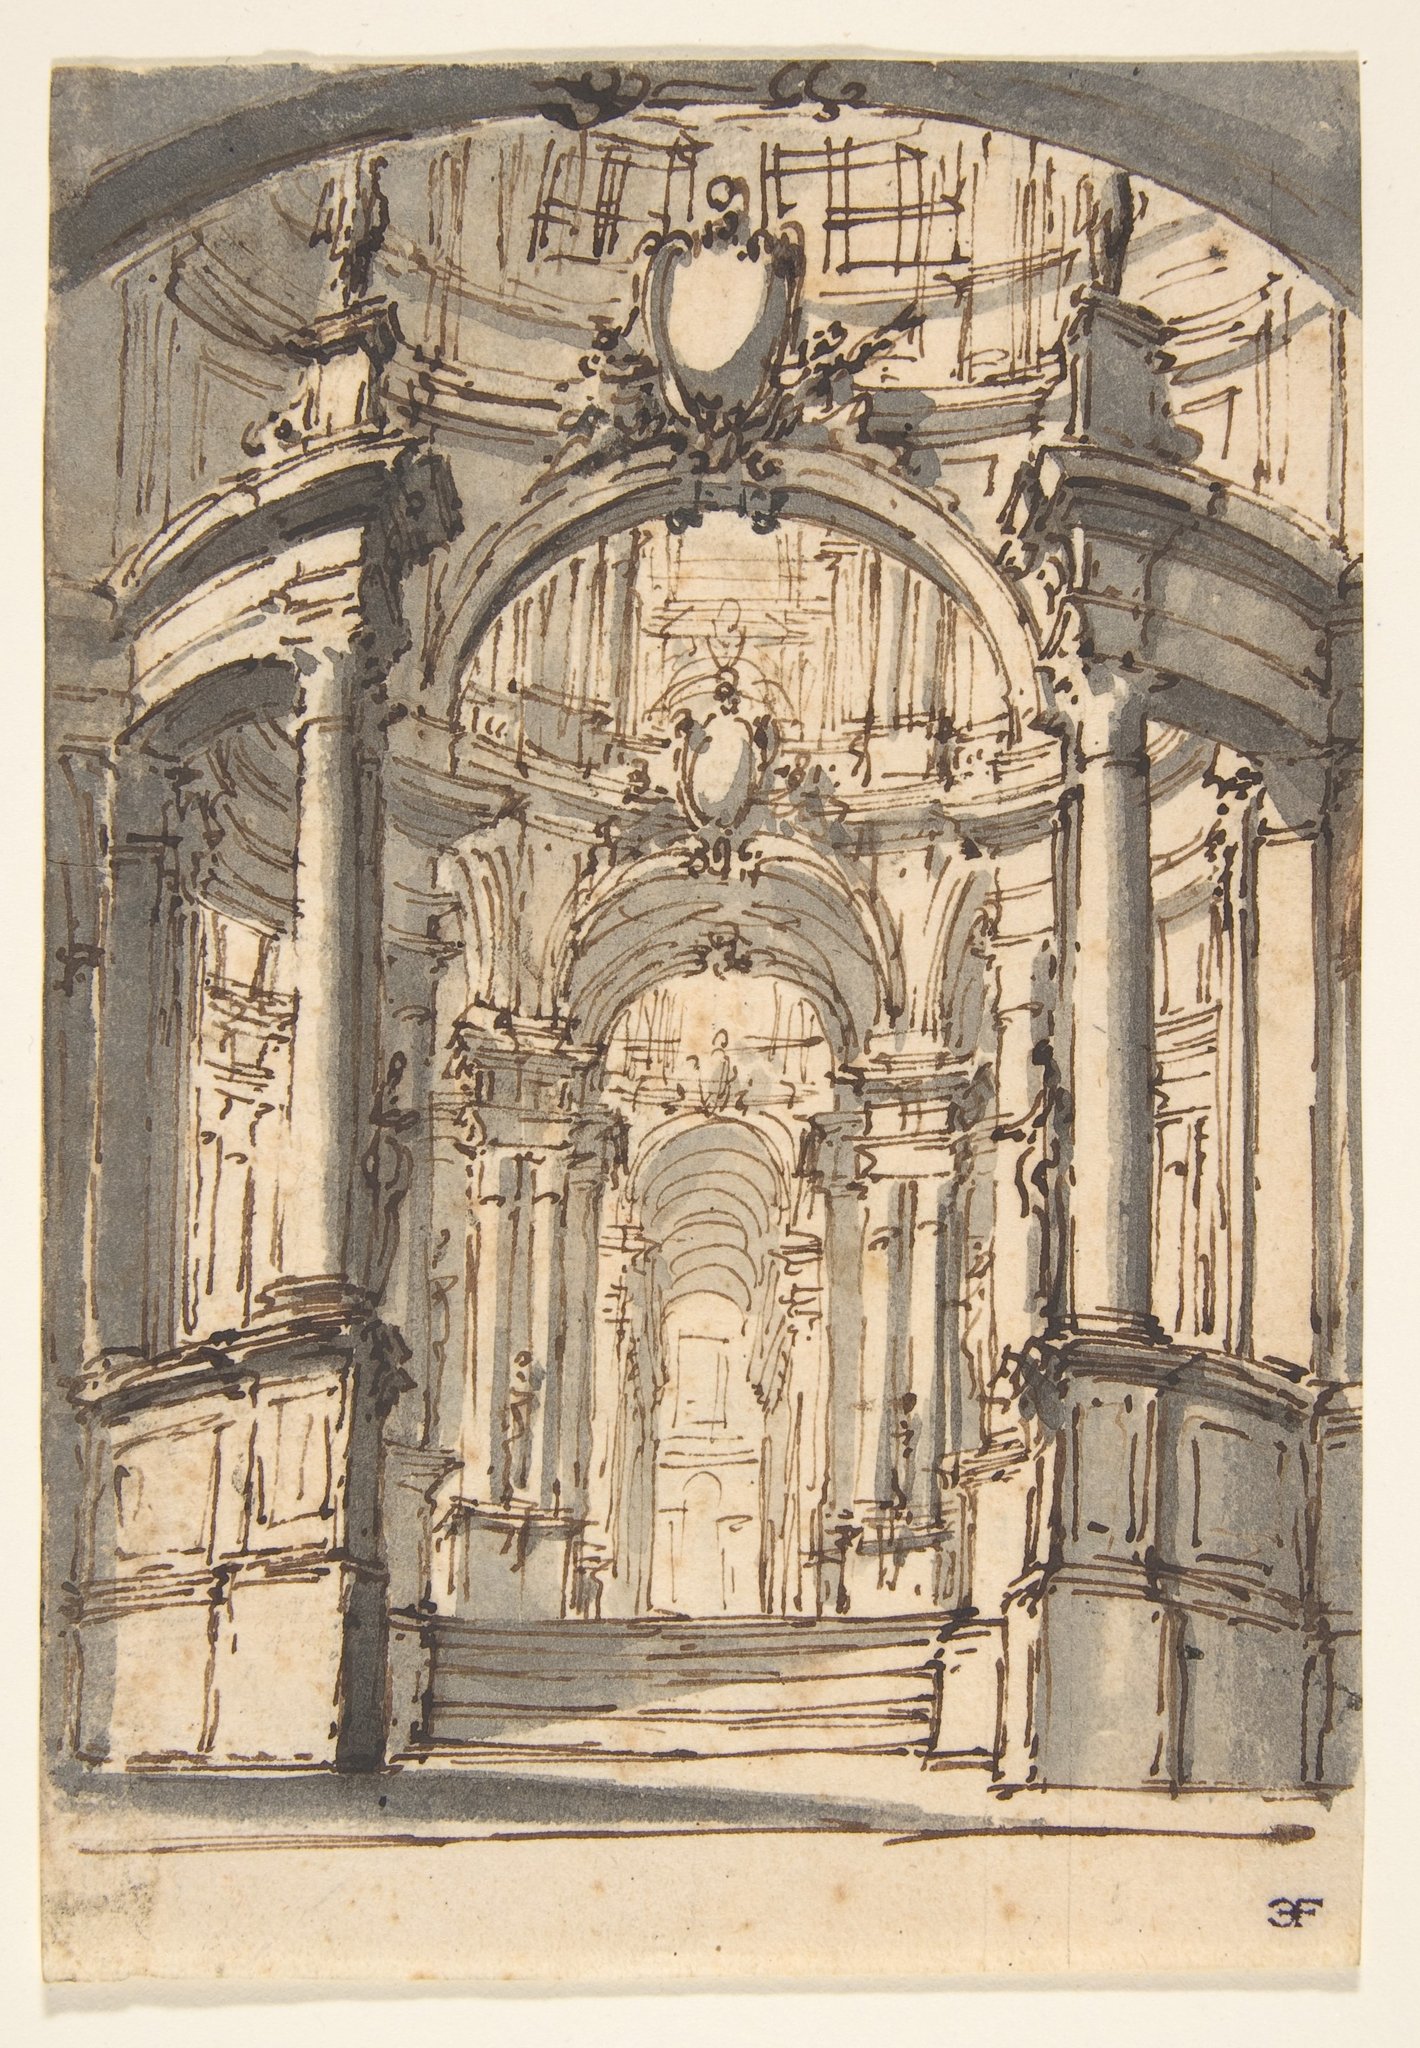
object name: drawing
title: Design for Stage Set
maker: giovanni battista natali iii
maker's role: artist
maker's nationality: italian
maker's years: 1698-1765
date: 1698-1765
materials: ink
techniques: brush, pen, wash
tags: columns,stage design